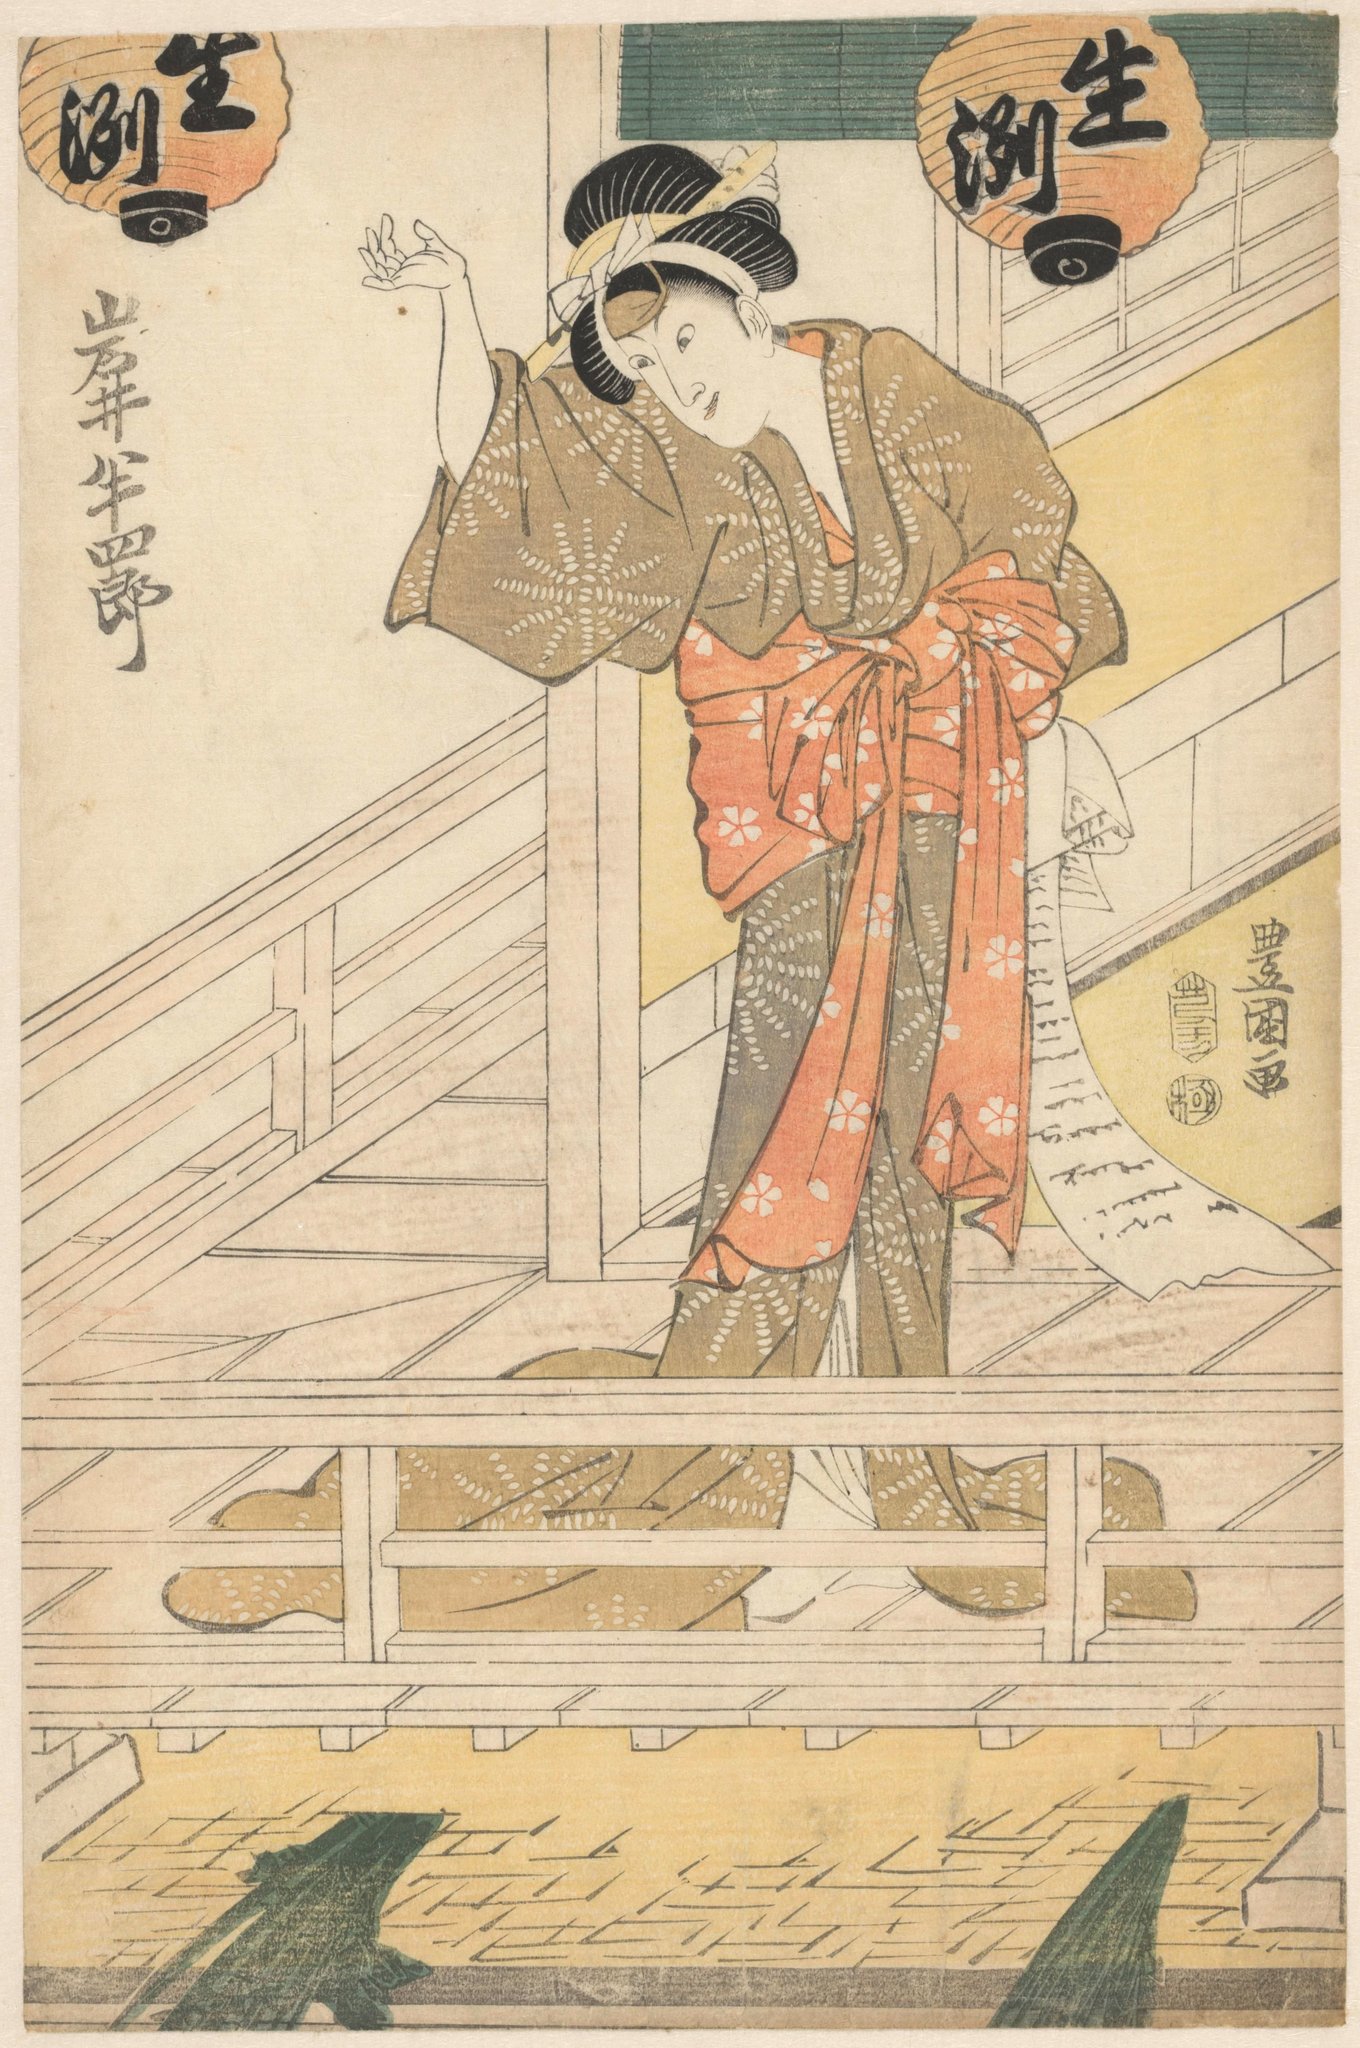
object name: print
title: Waitress Oritsu hiding a letter behind her back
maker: utagawa toyokuni (i)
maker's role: print maker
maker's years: 1769-1825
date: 1805-1812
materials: paper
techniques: woodcut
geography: japan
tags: group of actors, troupe; actors on the stage, balcony, letter, envelope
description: Kabuki acteur Iwai Hanshirô V in de rol van de serveerster Oritsu. Scene uit een toneelstuk waarbij Oritsu vanaf een balkon naar beneden kijkt terwijl ze een brief achter haar rug verbergt. Bovenste deel van een verticaal diptiek, waarbij op het onderste deel de kapper Gorôhachi staat afgebeeld.